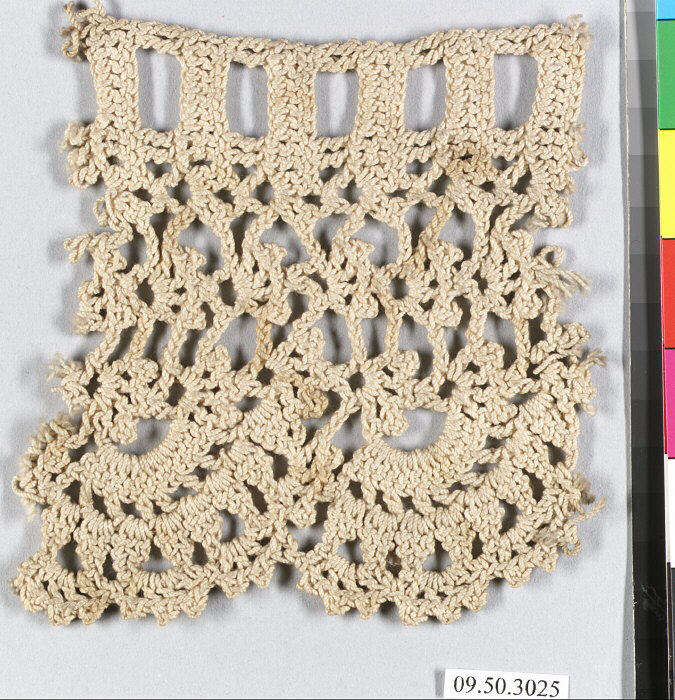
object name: piece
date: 1801-1900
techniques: crochet